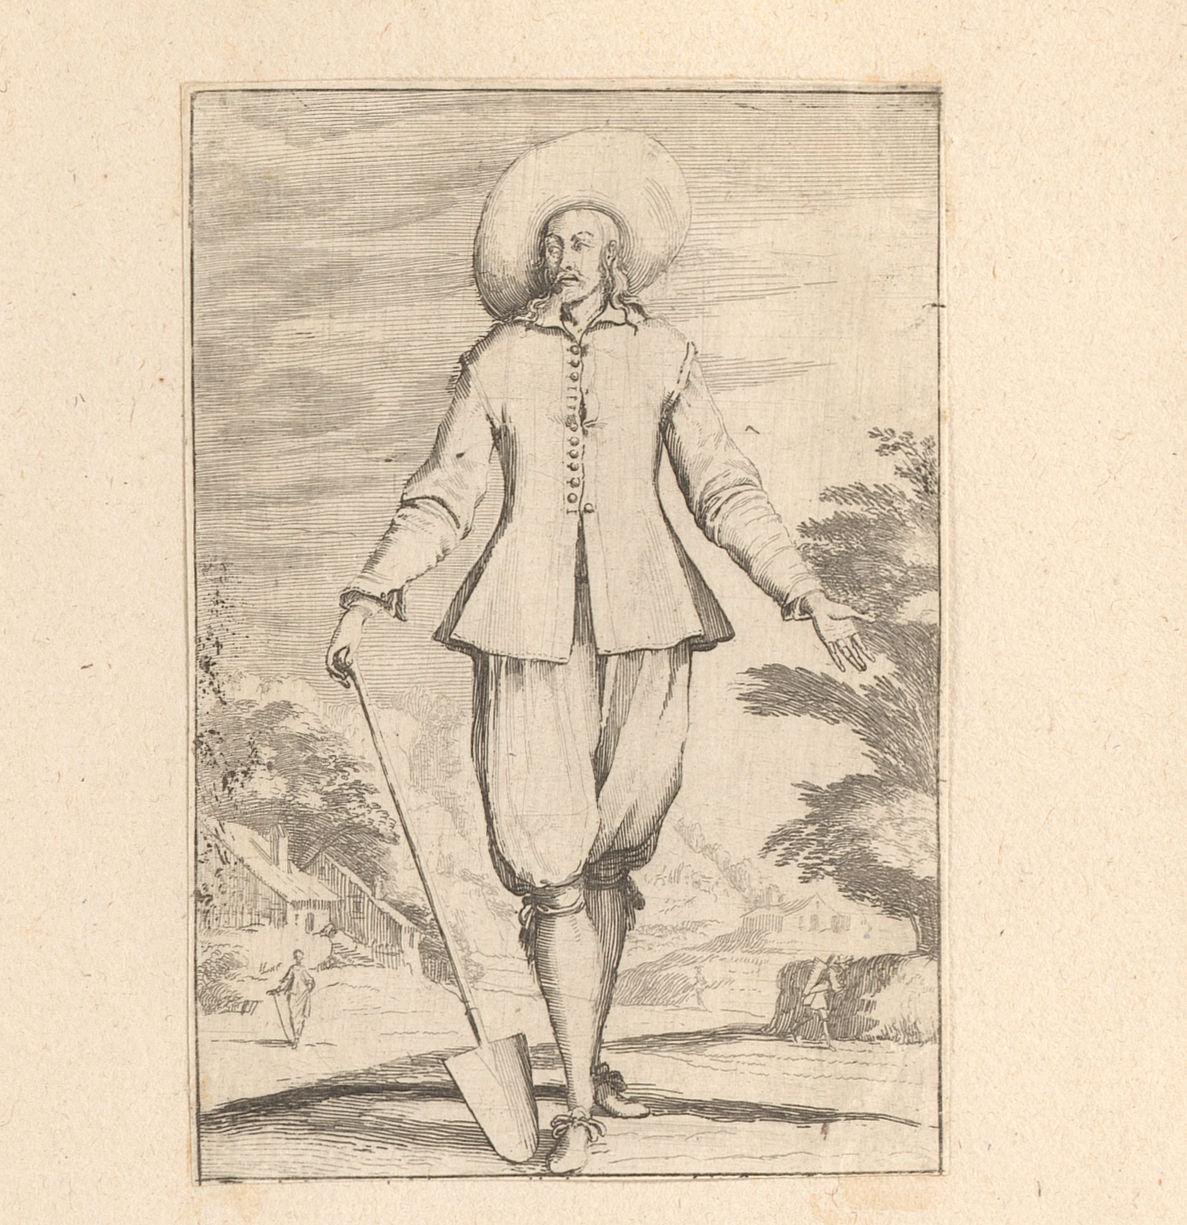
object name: album leaf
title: Les Modes de Metz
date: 1647-1701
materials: paper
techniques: etching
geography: metz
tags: gardening, folk costume, regional costume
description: Prent maakt deel uit van een 28-delige serie met verschillende figuren uit Metz in de regionale mode. Leclerc vervaardigde de platen te Metz. Landry gaf slechts twintig van de prenten in een serie uit.